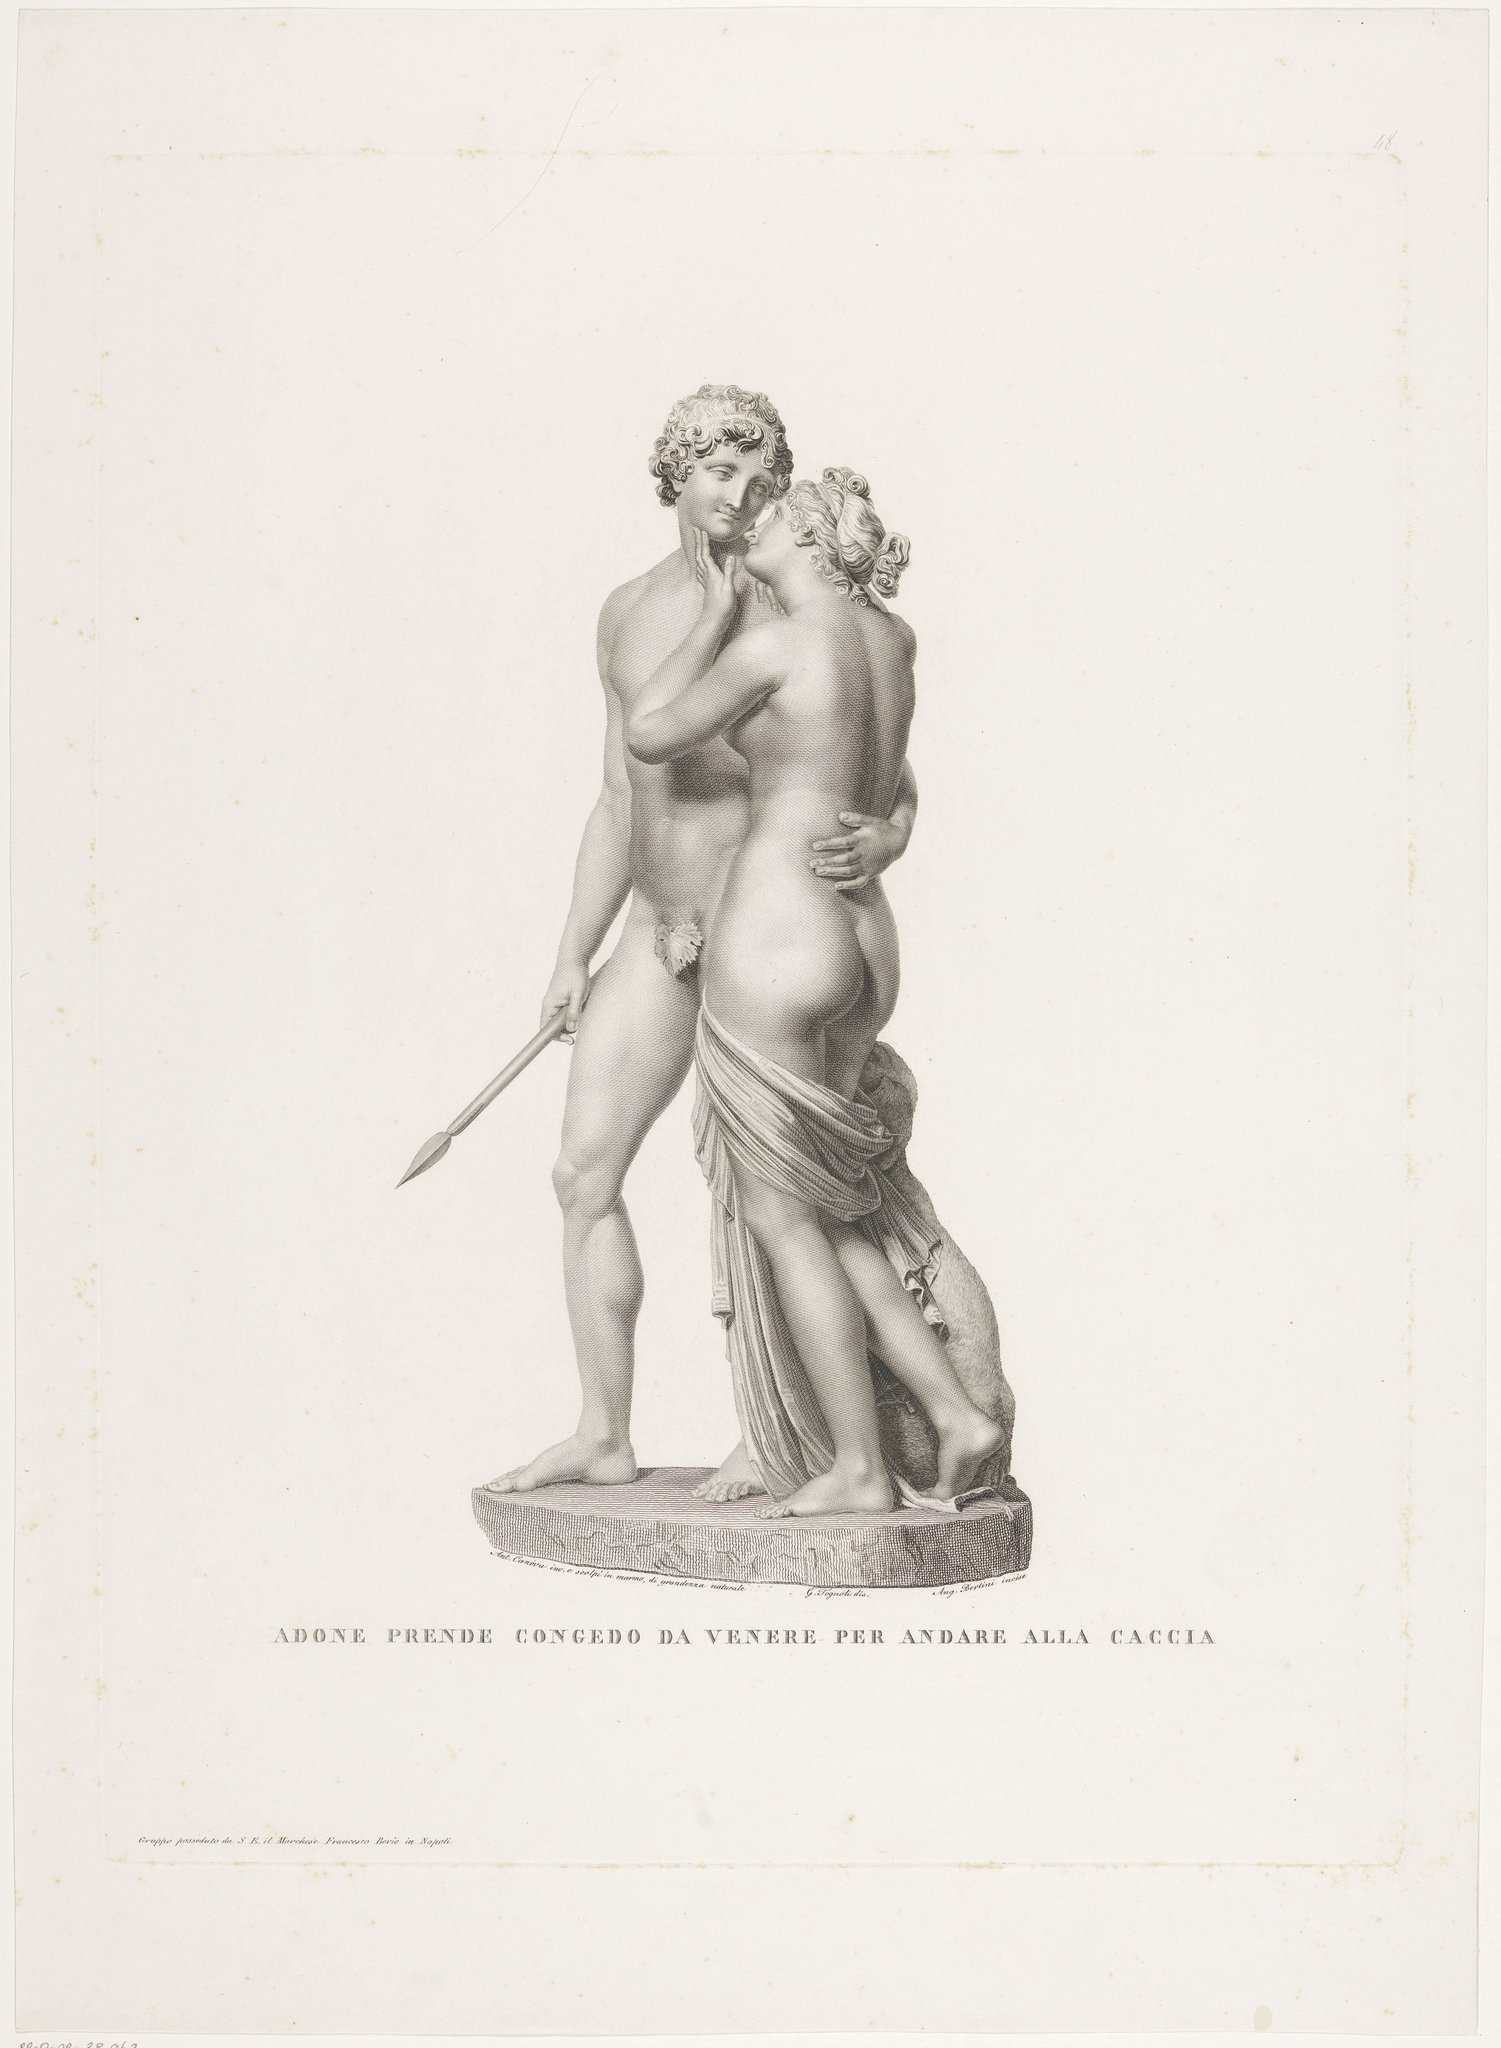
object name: print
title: Sculpturen van Antonio Canova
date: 1793-1838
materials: paper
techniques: engraving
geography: italy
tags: piece of sculpture, reproduction of a piece of sculpture, venus and adonis as lovers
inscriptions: collector's mark: Lugt 12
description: Deze prent maakt deel uit van een reeks van onbekende omvang met voorstellingen van sculpturen van Antonio Canova door verschillende prentmakers naar tekeningen van Giovanni Tognolli.Het beeld van Canova bevindt zich in Villa La Grange te Genève.